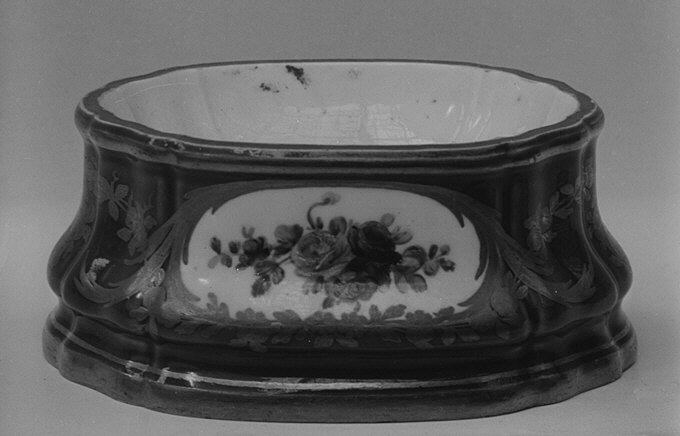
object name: salt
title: Salt (one of two) (part of a service)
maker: sèvres manufactory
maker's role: manufactory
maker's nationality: french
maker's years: 1740-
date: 1783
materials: soft paste porcelain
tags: flowers